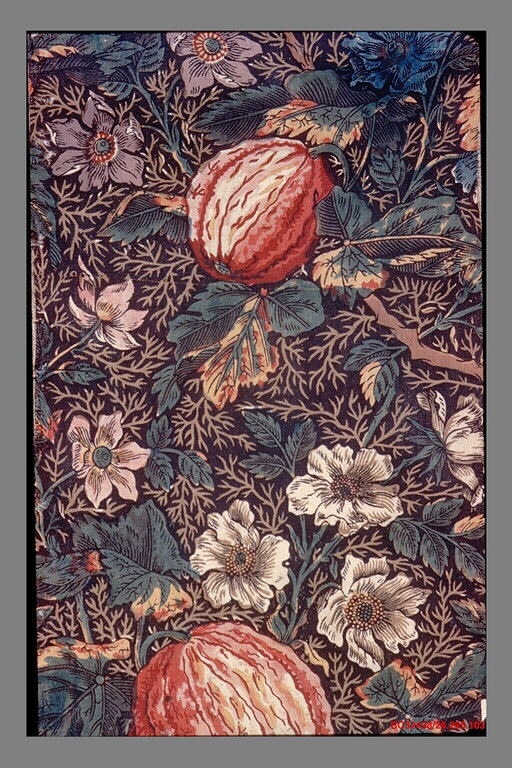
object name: floral print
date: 1795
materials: cotton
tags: fruit,flowers,leaves